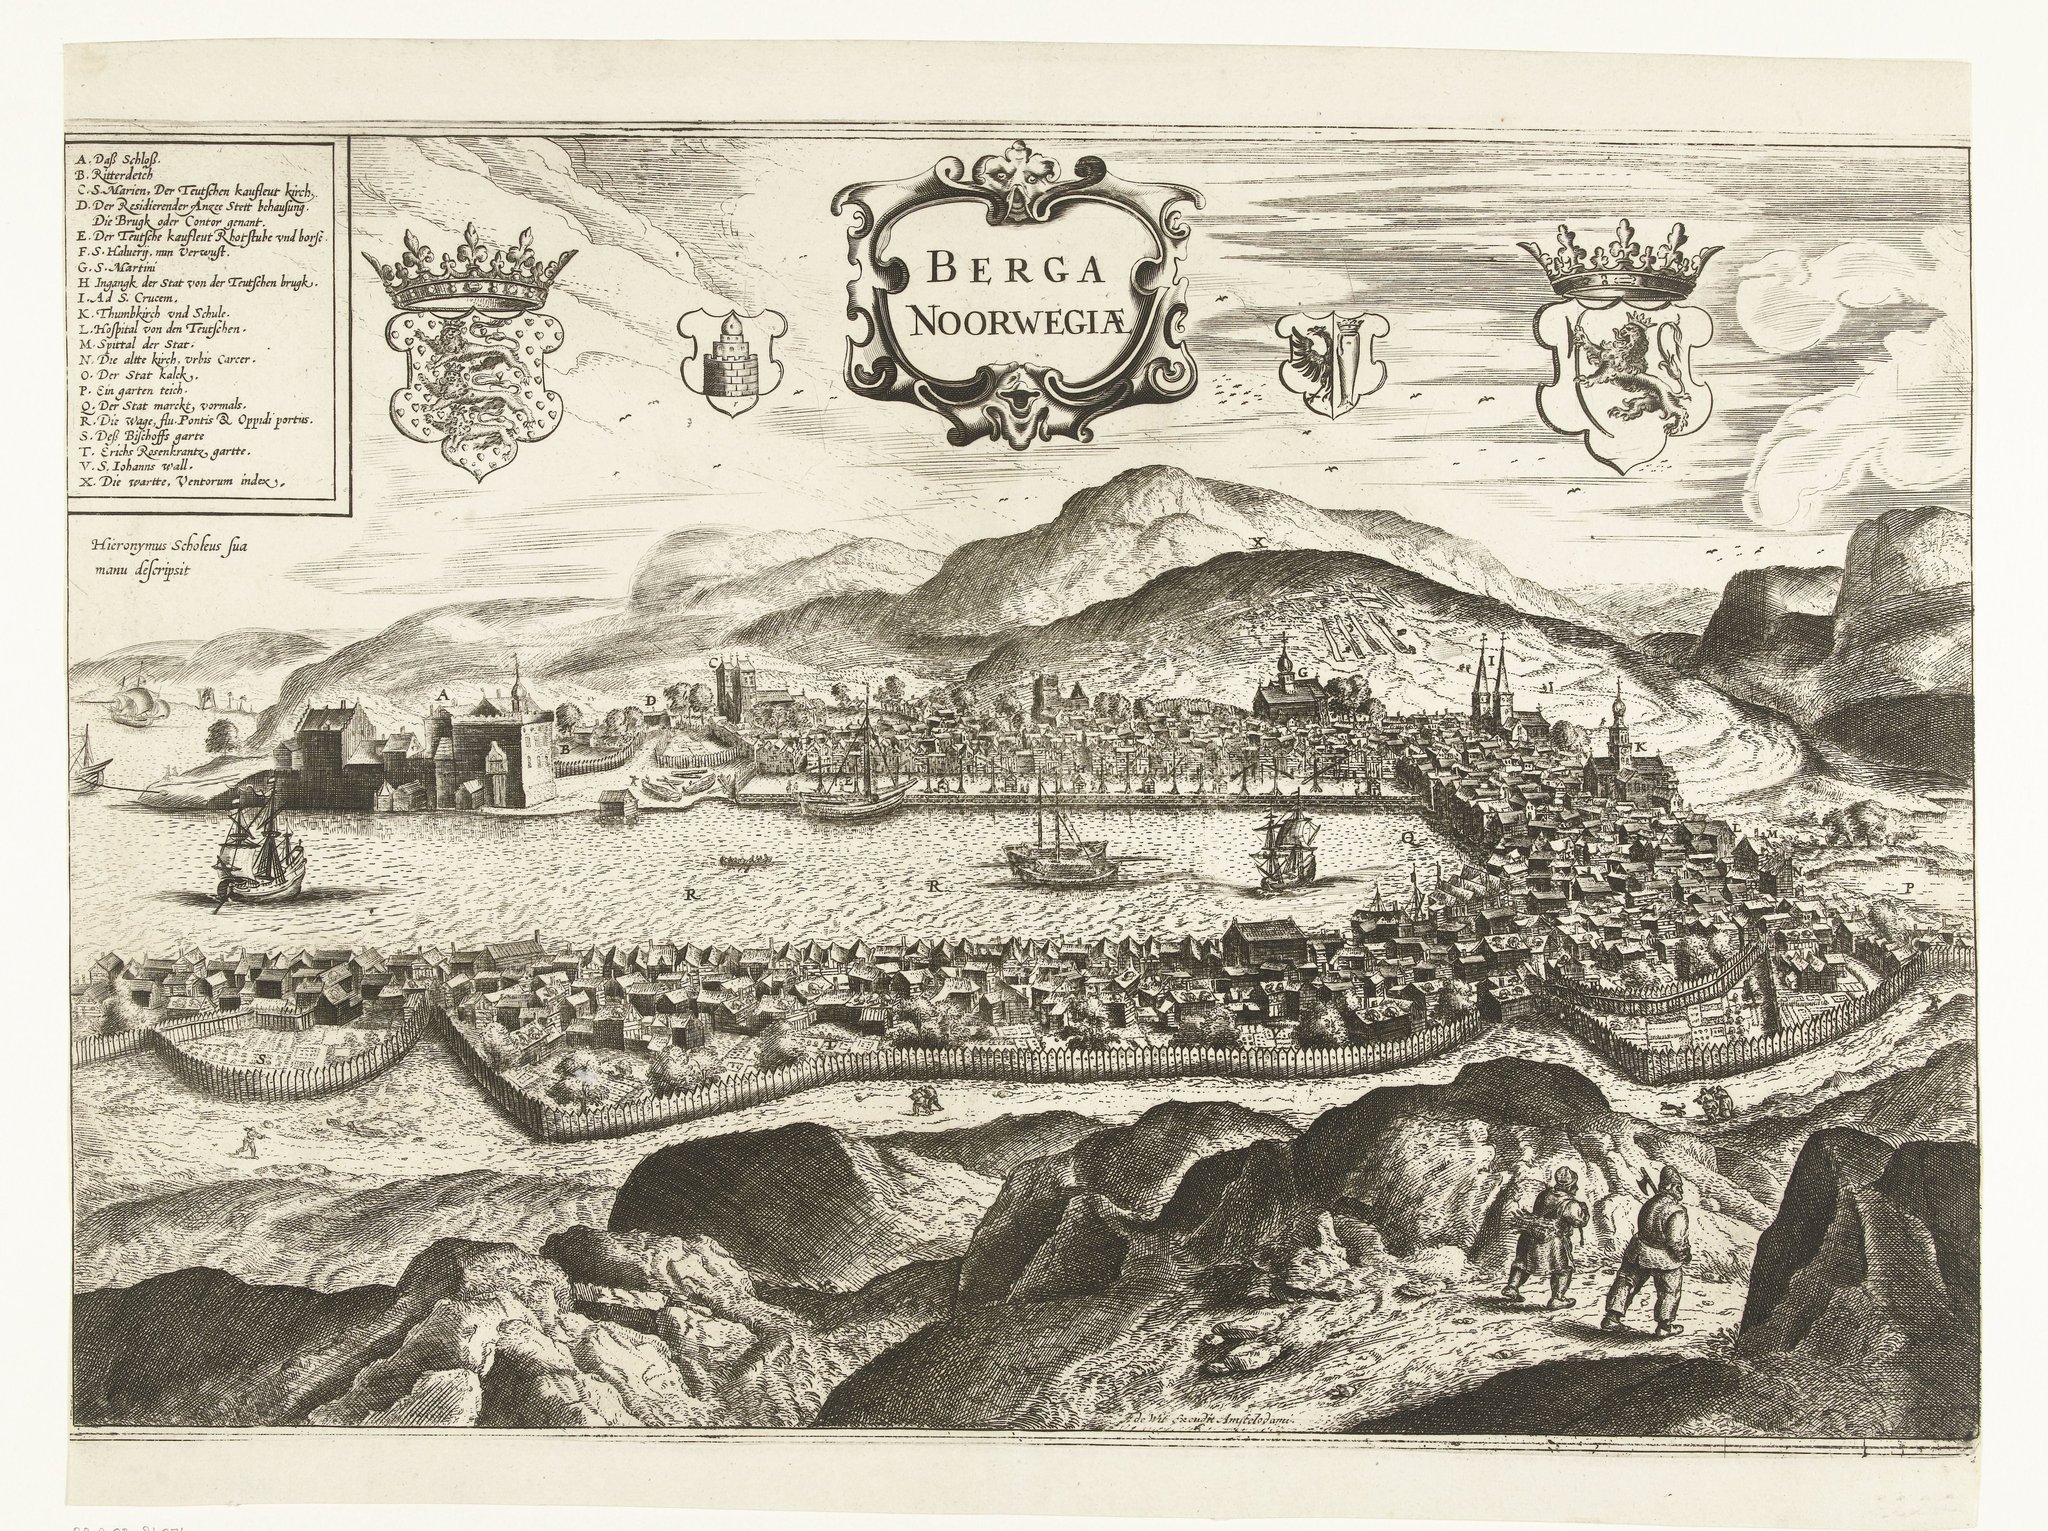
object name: print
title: Berga Noorwegiae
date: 1585-1588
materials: paper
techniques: engraving, etching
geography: germany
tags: bergen, slag bij bergen (noorwegen)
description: Gezicht op de havenstad Bergen in Noorwegen. In de lucht de wapens van de stad en het land, links de legenda A-X in het Duits. Waarschijnlijk uitgegeven naar aanleiding van het gevecht met de Engelse vloot in de haven op 10 augustus 1665.